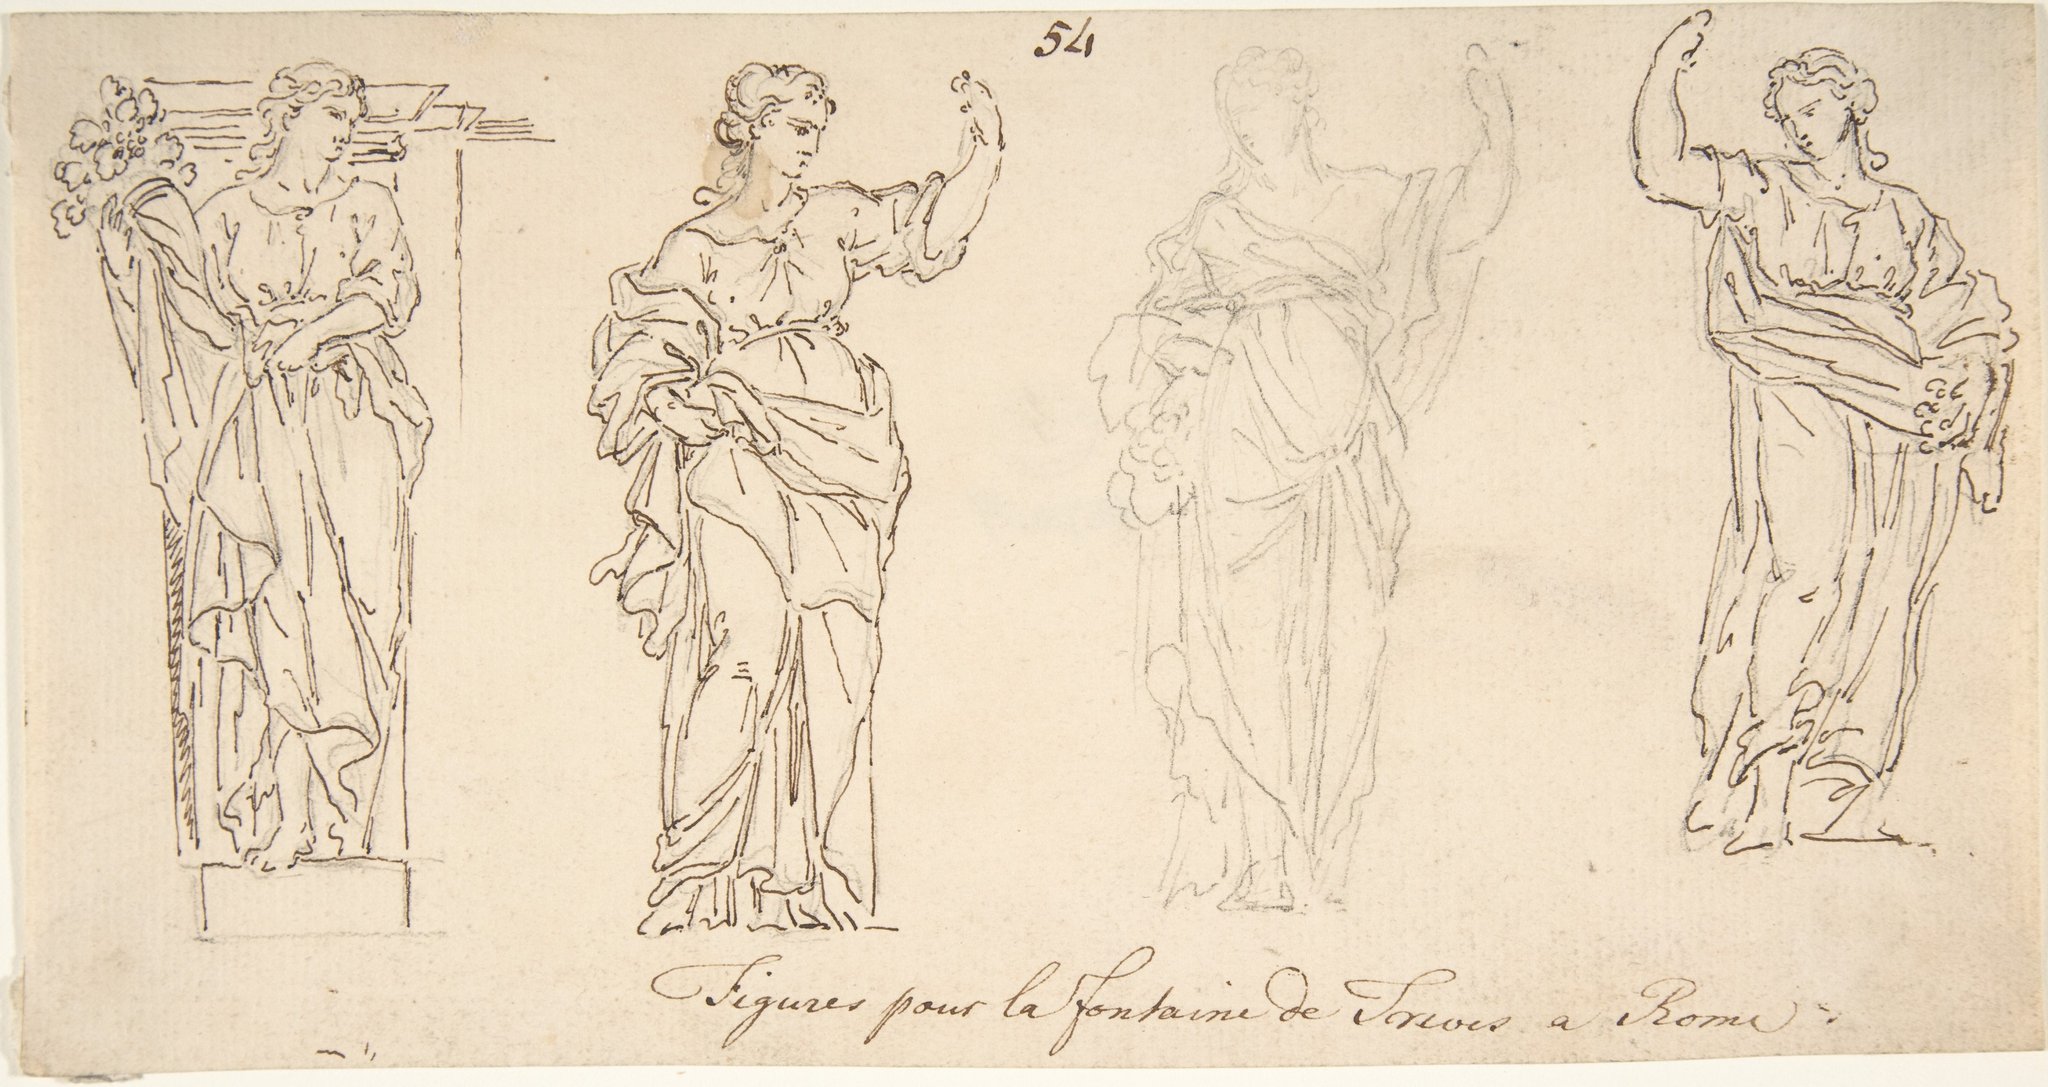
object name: drawing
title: Design for Female Figures for the Trevi Fountain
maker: anonymous, french, 18th century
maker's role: artist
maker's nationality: french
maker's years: 1700-1800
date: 1701-1800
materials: graphite, ink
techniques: pen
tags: women